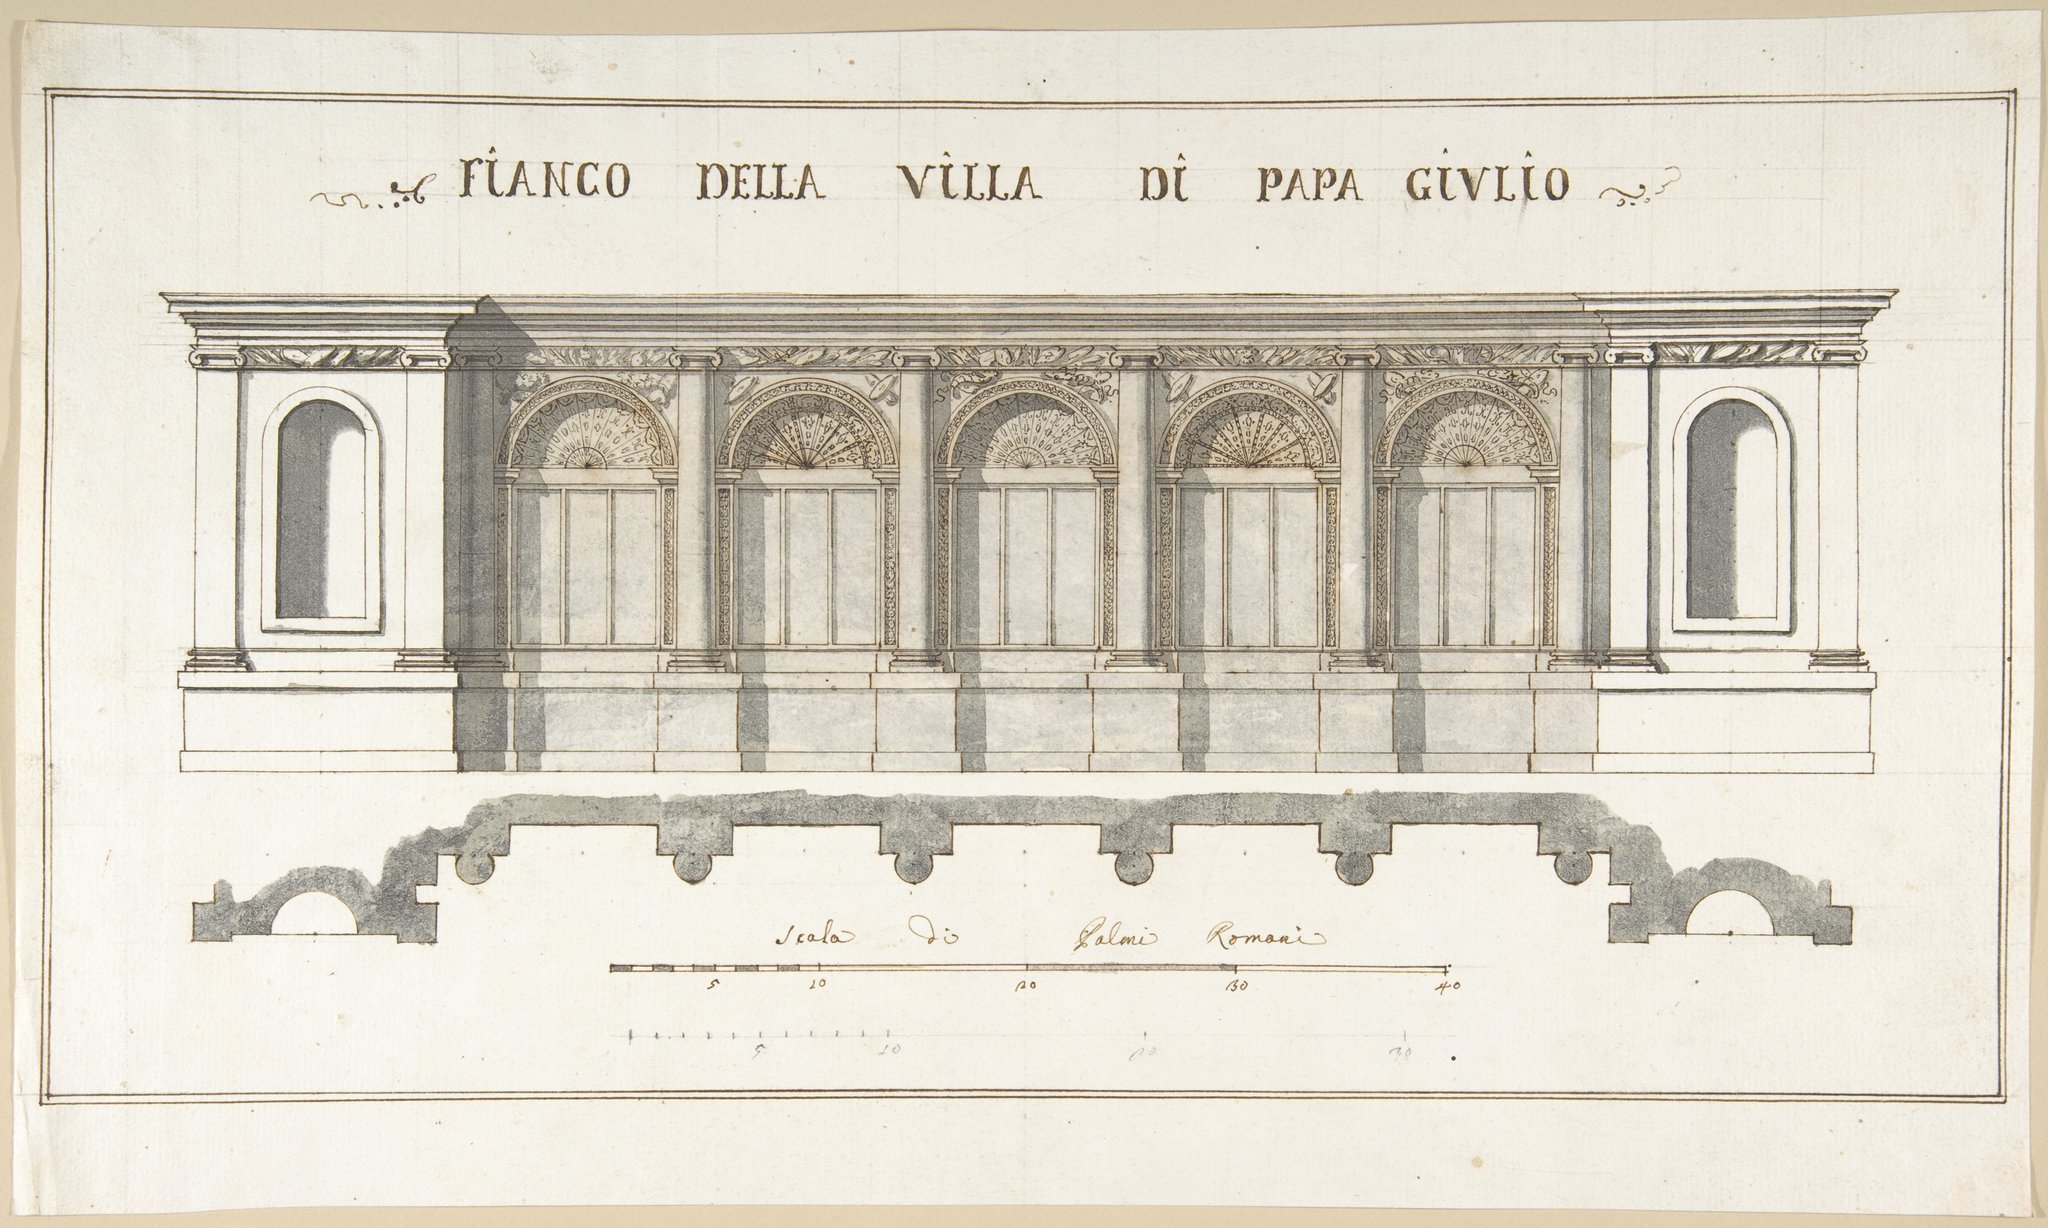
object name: drawing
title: Side Elevation of the Villa of Pope Julius [III.]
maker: pietro paolo coccetti (cocchetti)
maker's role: artist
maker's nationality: italian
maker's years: 1710-1727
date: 1710-1727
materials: graphite, ink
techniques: brush, pen, wash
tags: architecture